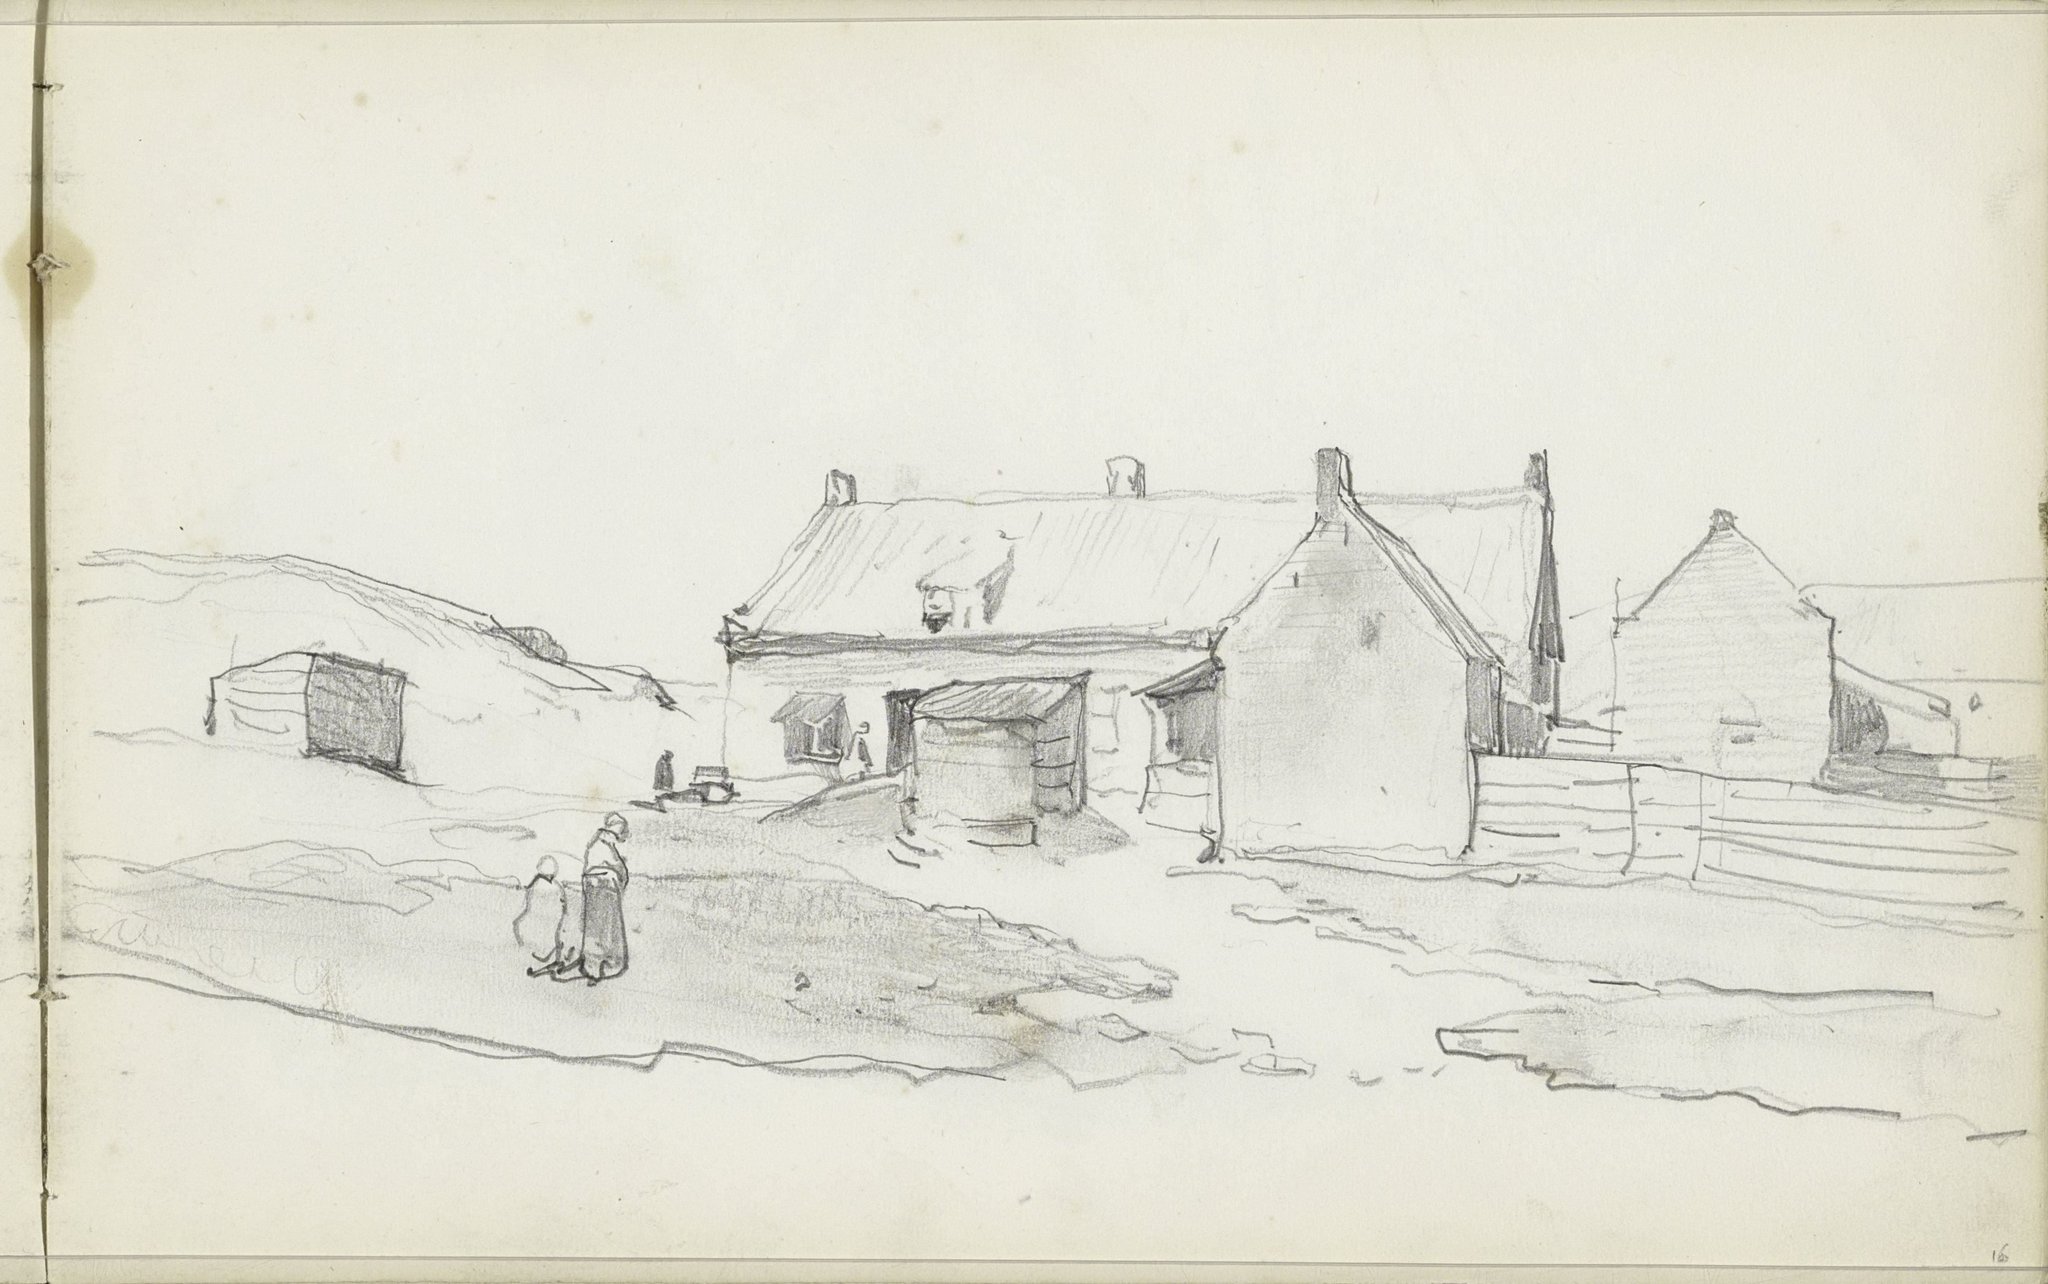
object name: sketchbook leaf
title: Huizen op het duin bij Scheveningen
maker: johannes bosboom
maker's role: draughtsman, painter, print maker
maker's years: 1817-1891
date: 1873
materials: paper, pencil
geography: scheveningen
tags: dunes (sea not visible); in the dunes, cottage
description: Blad 16 recto uit een schetsboek met 39 bladen.